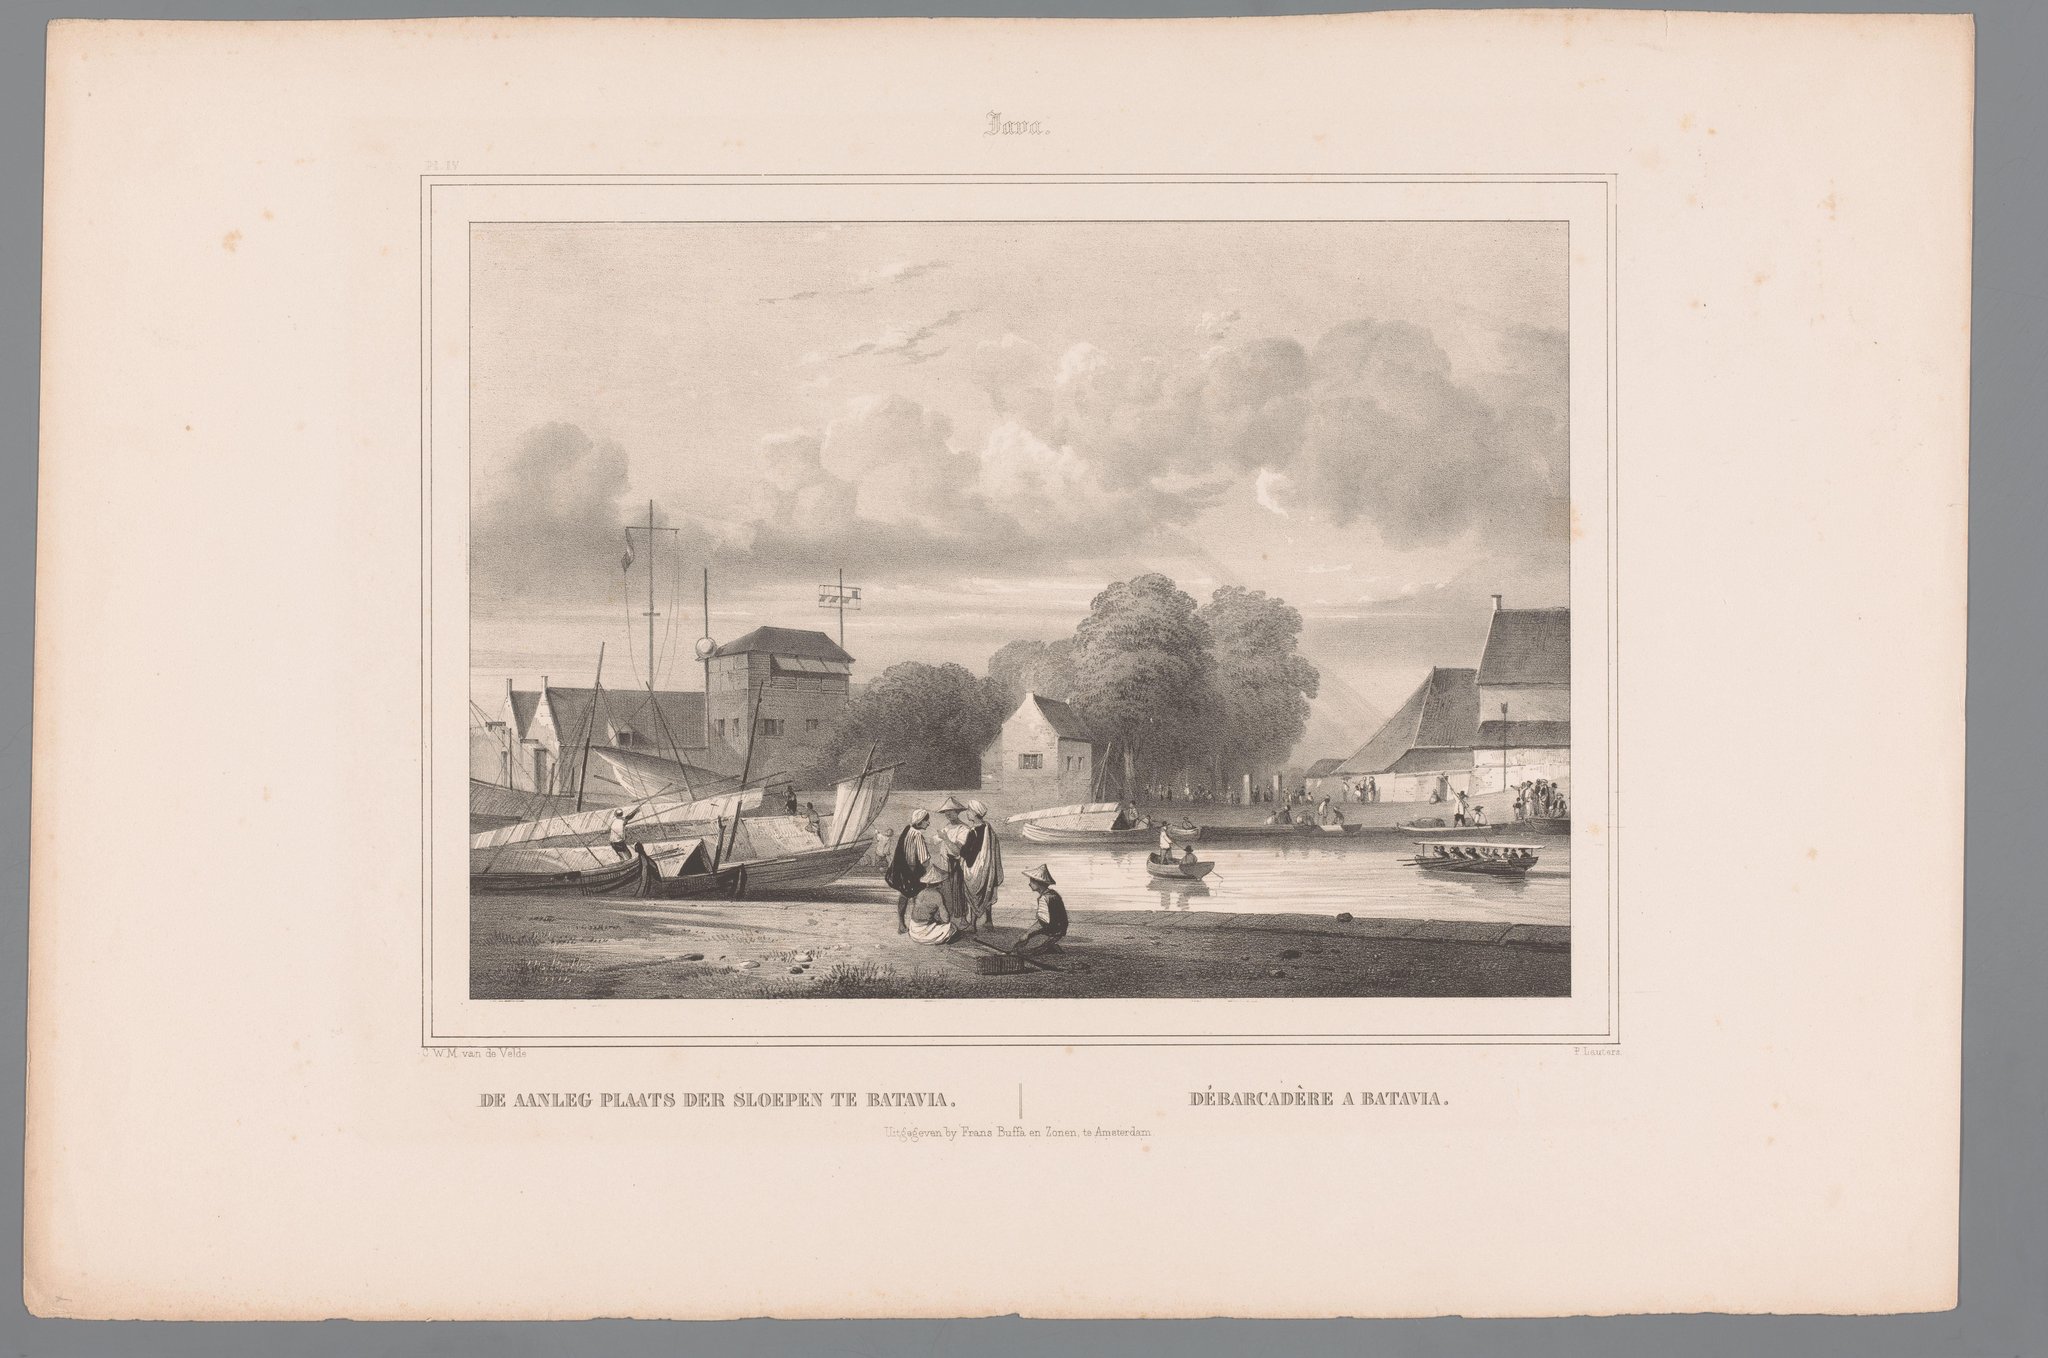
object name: print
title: Gezigten uit Neêrlands Indië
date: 1847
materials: paper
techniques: lithograph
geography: amsterdam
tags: sailing-ship, sailing-boat, sea (seascape) (+ landscape with figures, staffage), batavia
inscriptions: collector's mark: Lugt 2228